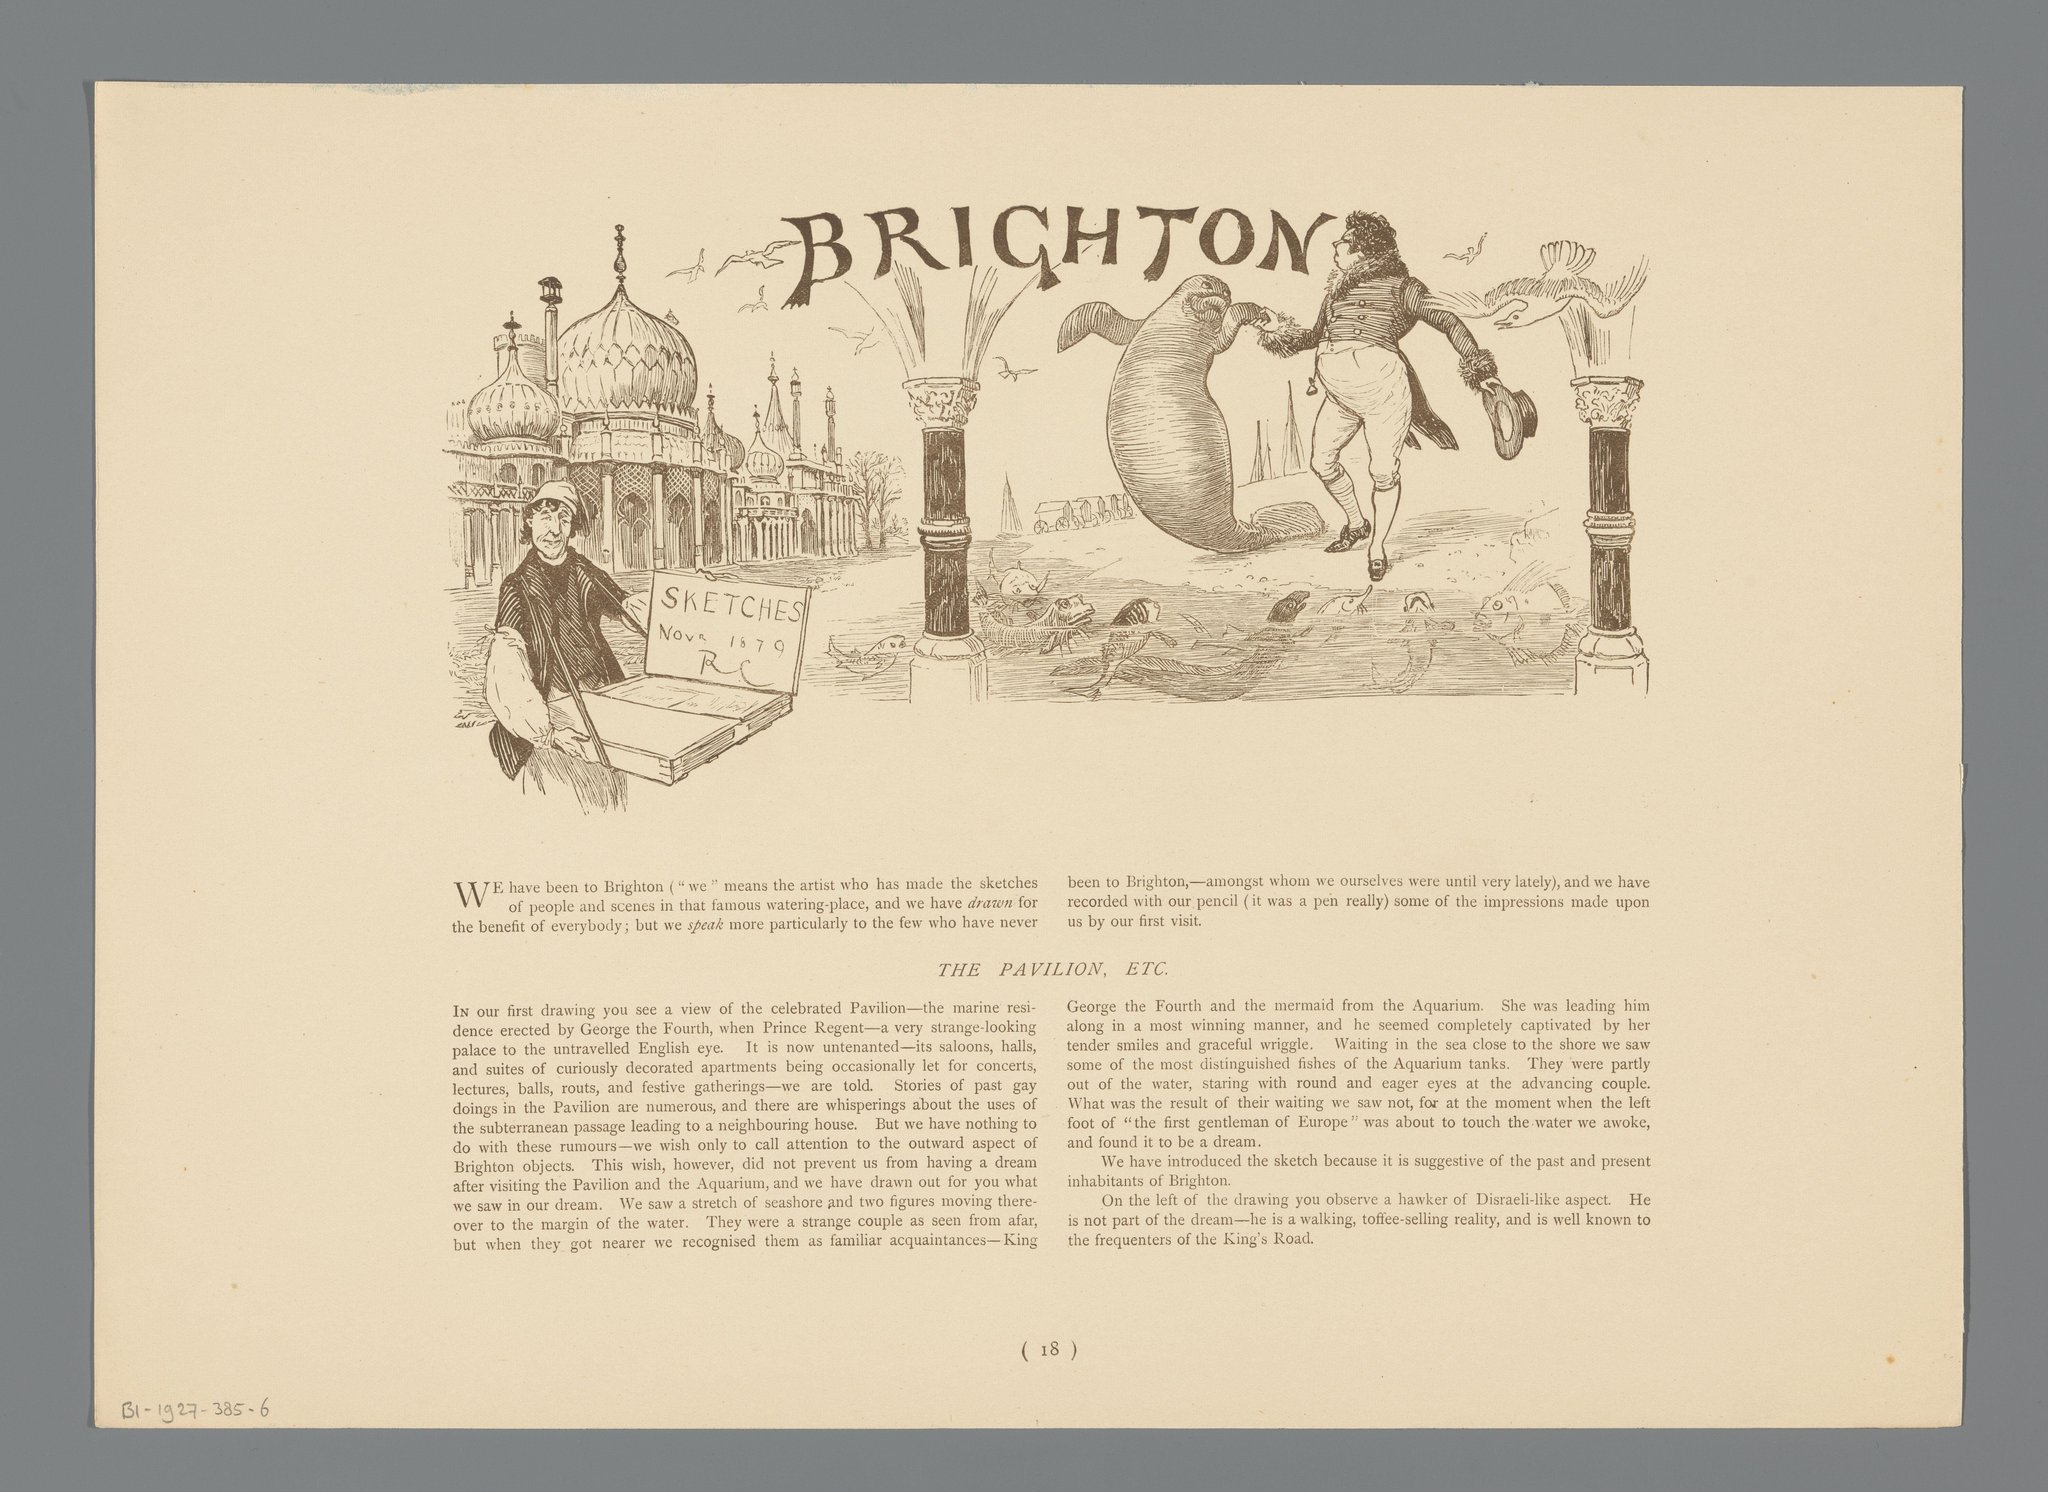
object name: print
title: Man met zeehond aan het strand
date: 1889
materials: paper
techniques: letterpress printing, engraving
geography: london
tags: beach (as place of recreation), seals (circus performance), swimming mammals: seal, coast (+ landscape with figures, staffage)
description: Prent uit: Gleanings from the Graphic. Londen: George Routledge & Sons, 1889. Dit werk is een bundel van diverse illustraties die eerder verschenen in verschillende jaargangen van het Engelse weekblad 'The Graphic'. De bundel is na het overlijden van Randolph Caldecott uitgegeven.